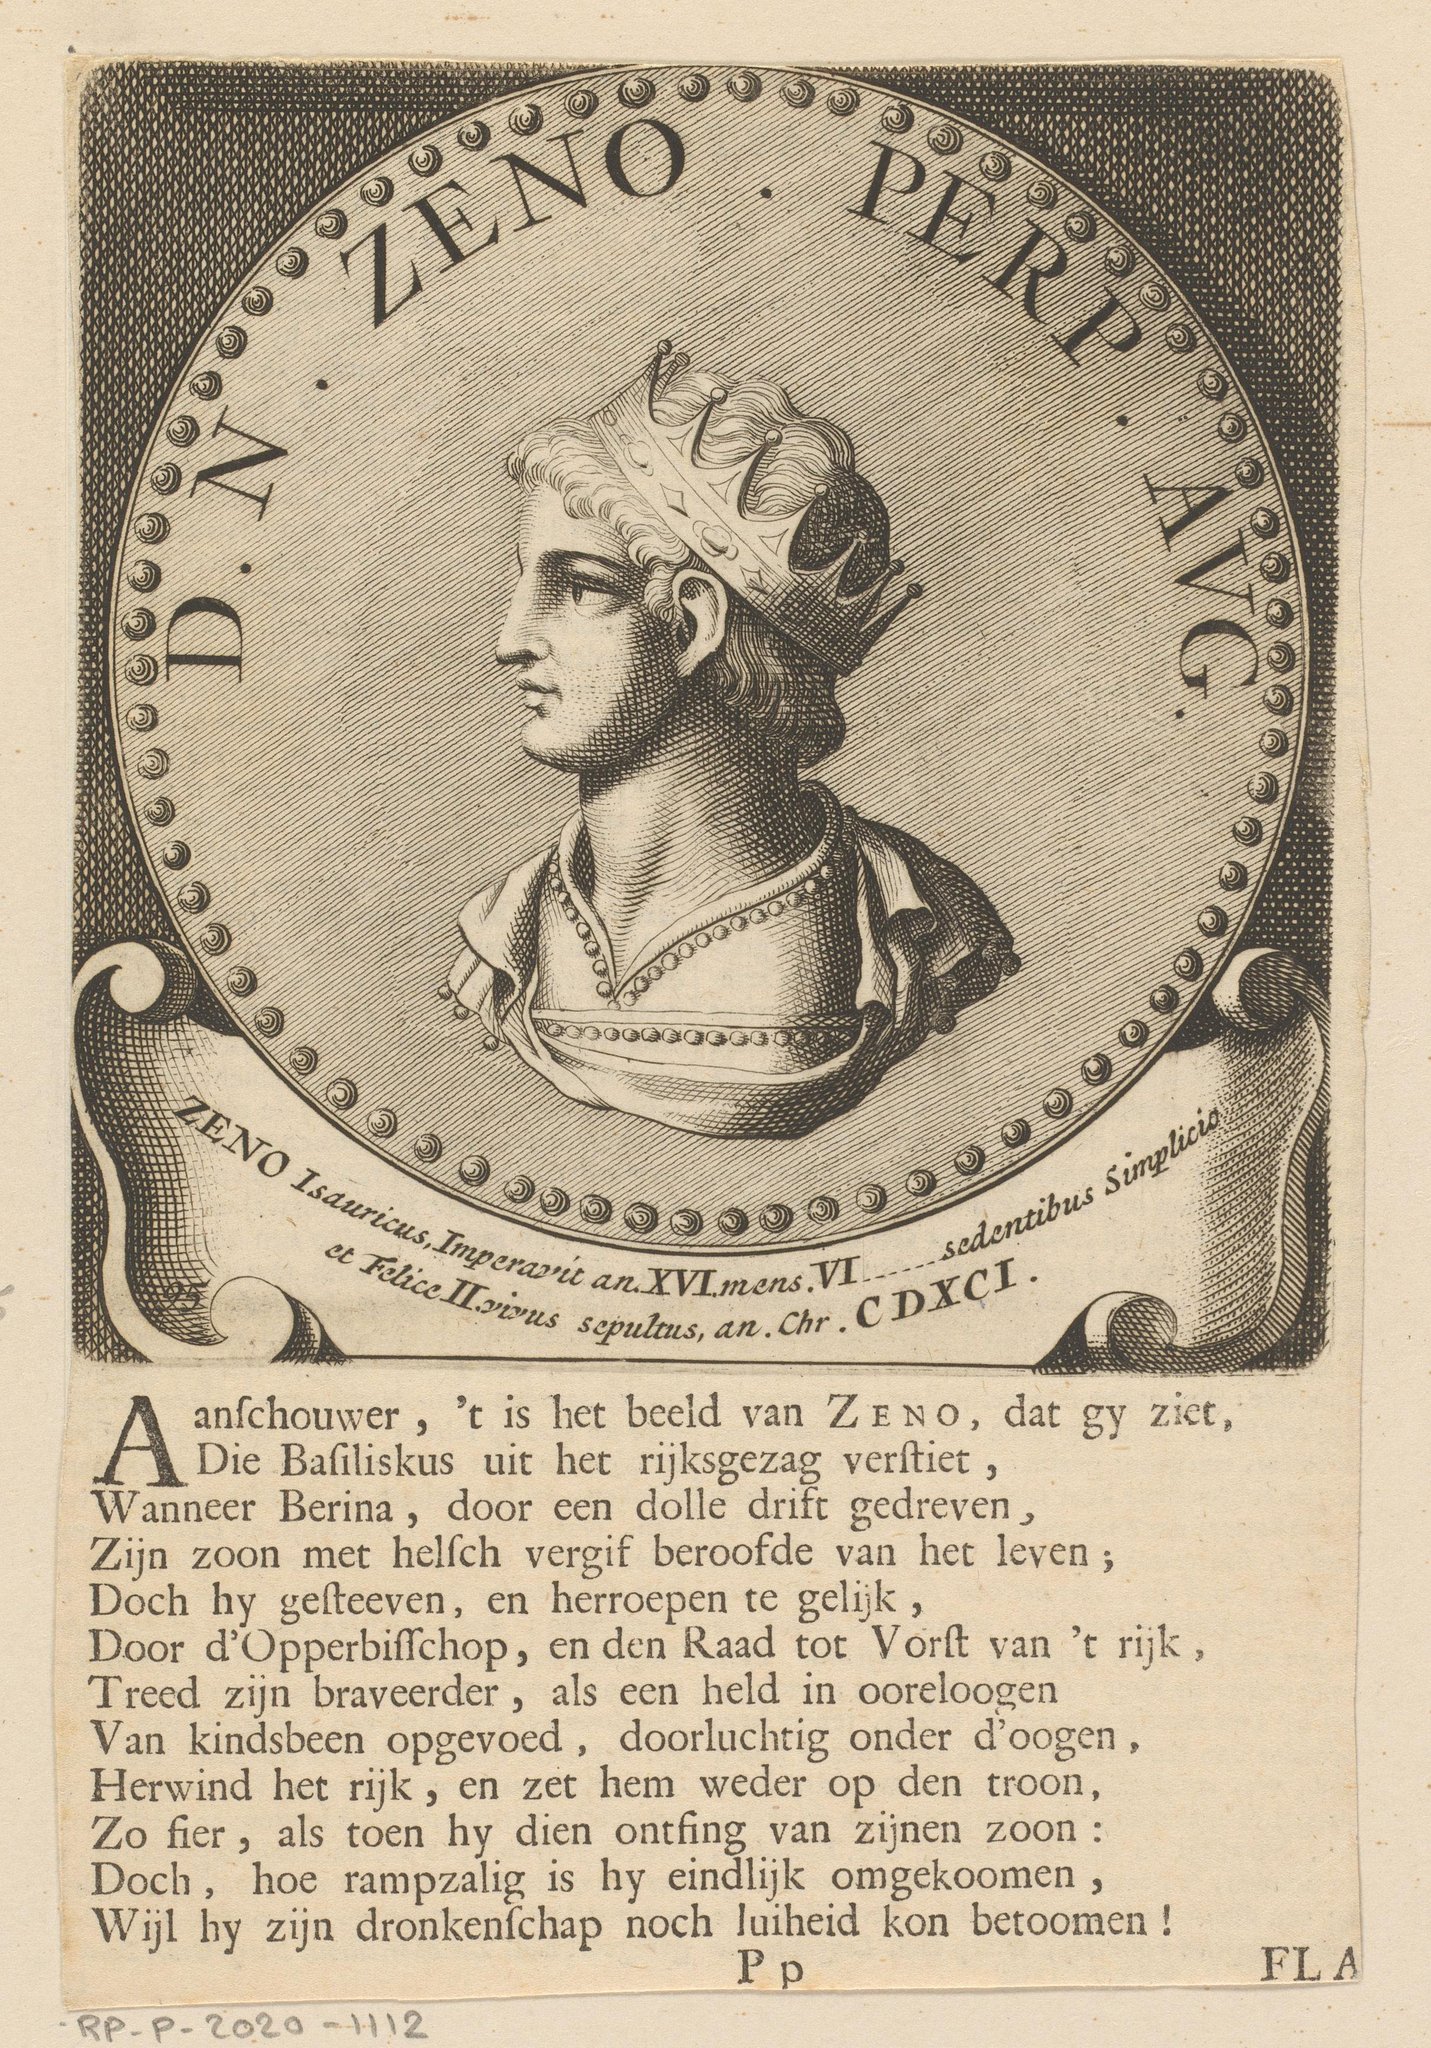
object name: print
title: Portret van keizer Zeno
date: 1697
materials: paper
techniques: engraving, etching, letterpress printing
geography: utrecht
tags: historical persons, emperor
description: Prent uit: Bogaert, Abraham. De Roomsche monarchy, vertoont in de muntbeelden der westersche en oostersche keizeren (...). Utrecht: François Halma en Willem van de Water, 1697, p. 297. Eerste staat verschenen in een grotere prent met twaalf portretten, gedateerd 1695.